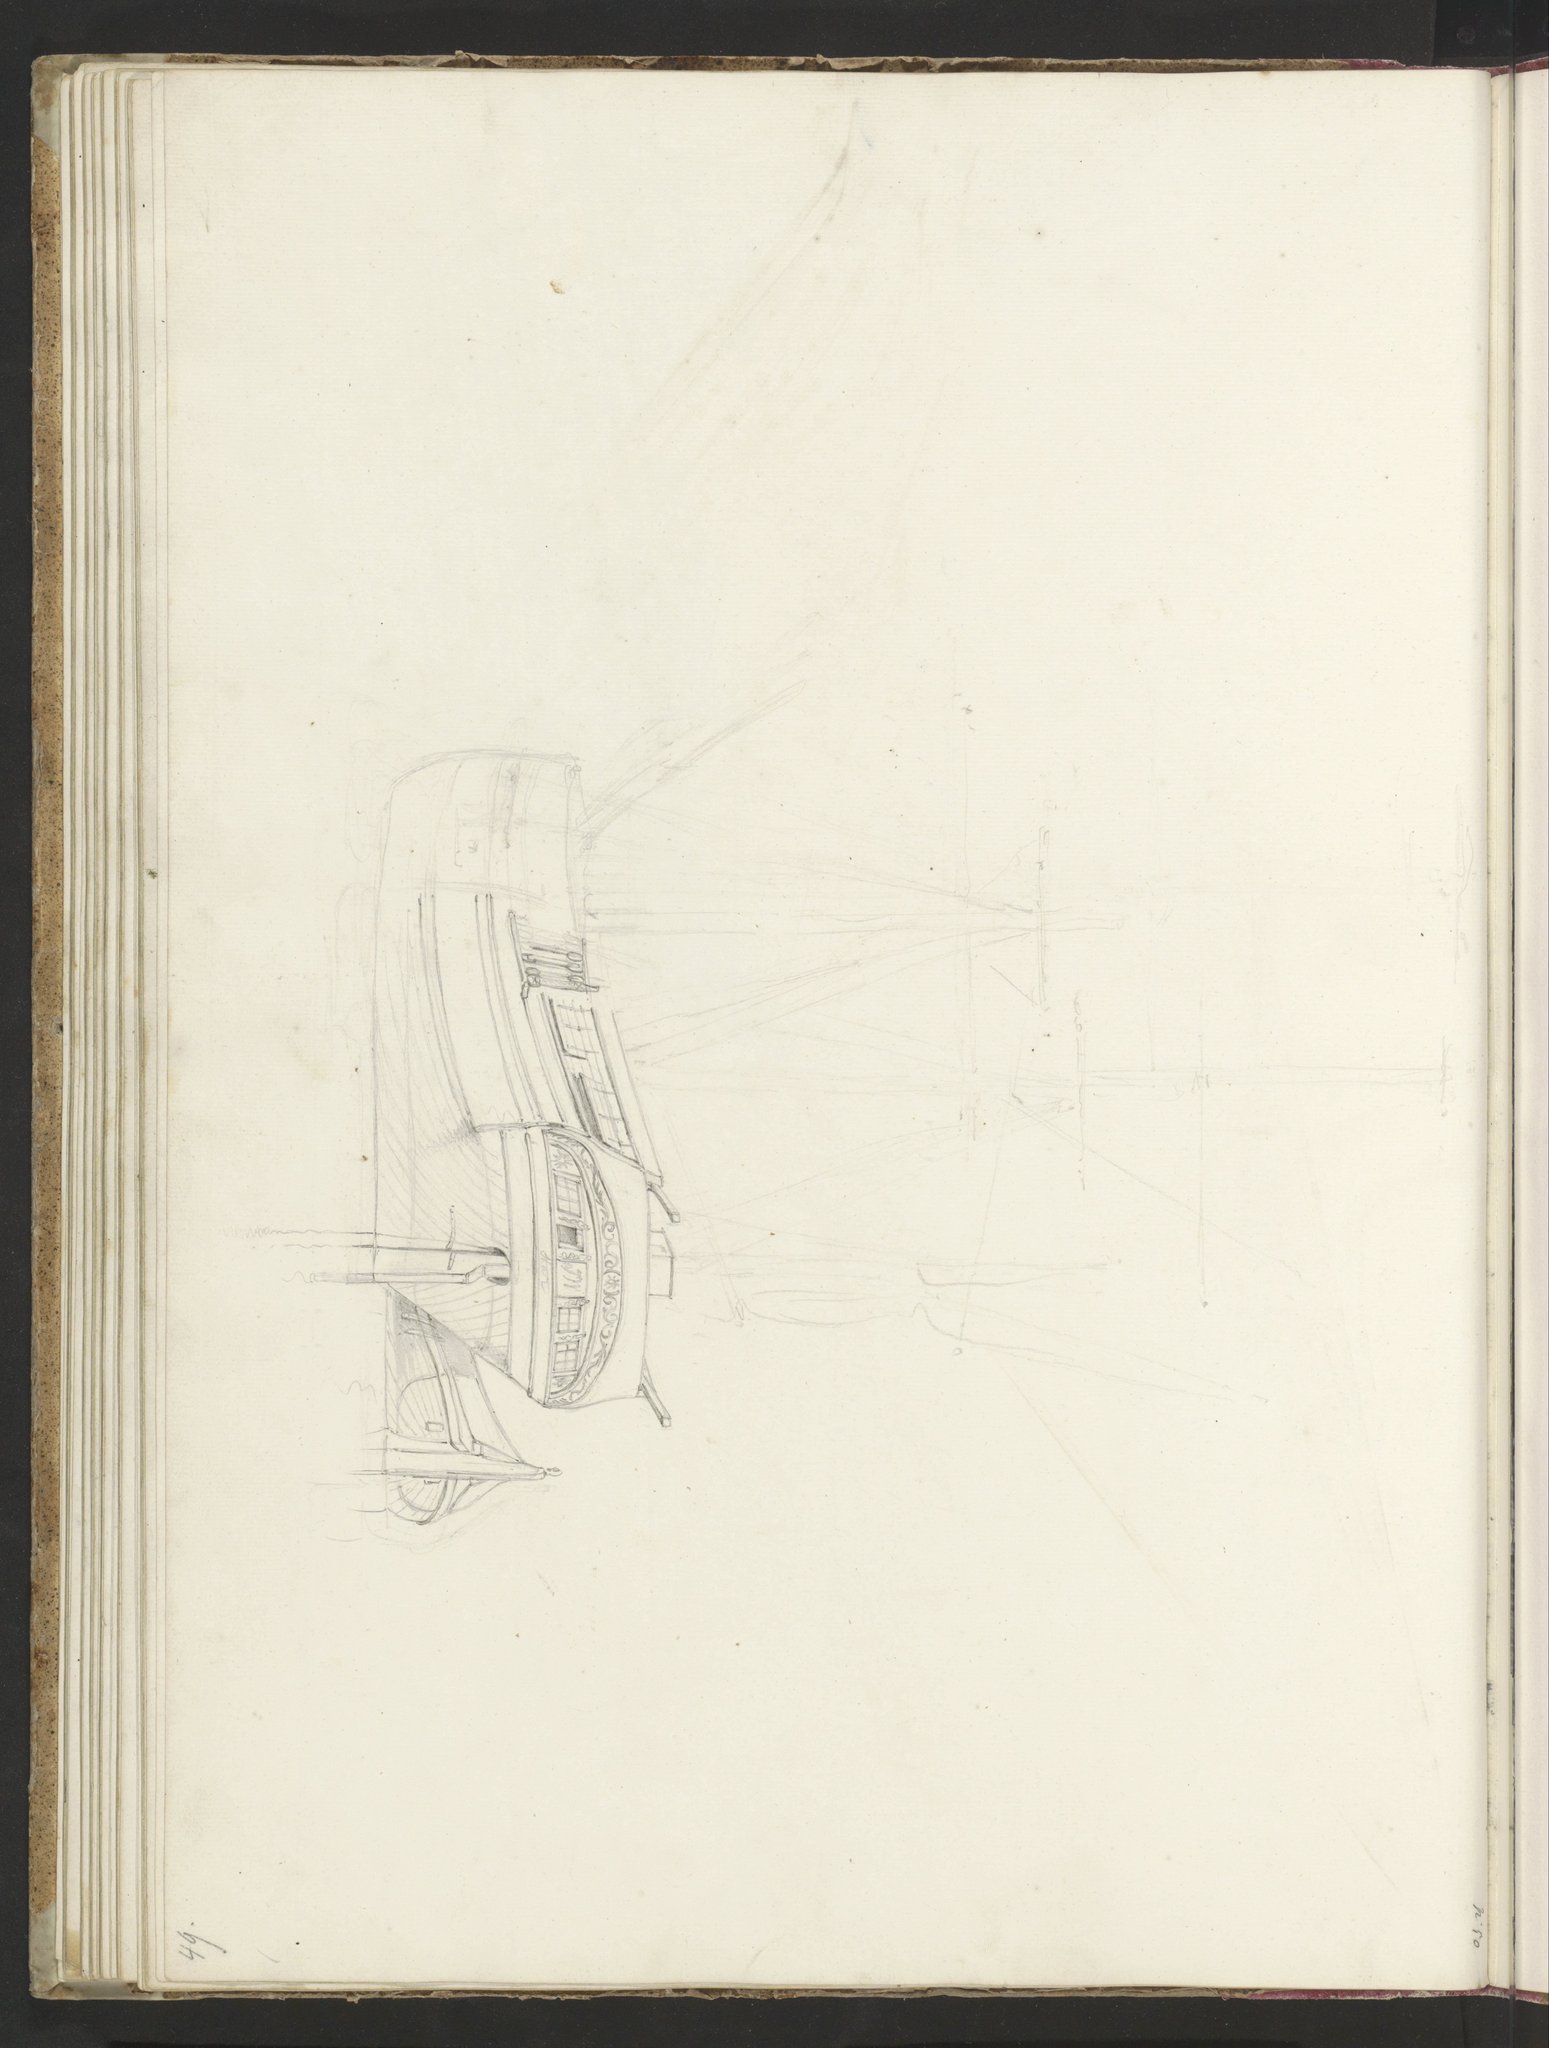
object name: sketchbook leaf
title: Zeilschip JW Star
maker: johannes christiaan schotel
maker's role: draughtsman, painter, print maker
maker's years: 1787-1838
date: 1797-1838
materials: paper, pencil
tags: sailing-ship, sailing-boat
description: Naast het schip ligt een tweede schip voor anker. Blad 49 verso uit een schetsboek met 65 bladen.